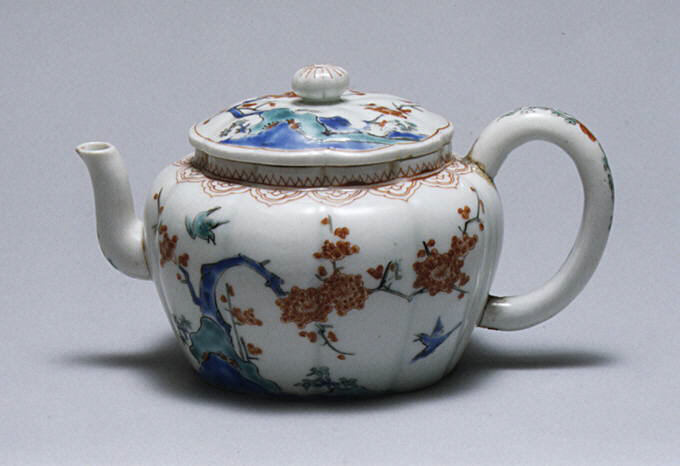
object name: wine pot with cover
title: Wine pot and cover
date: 1667-1700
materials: hard paste porcelain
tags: flowers